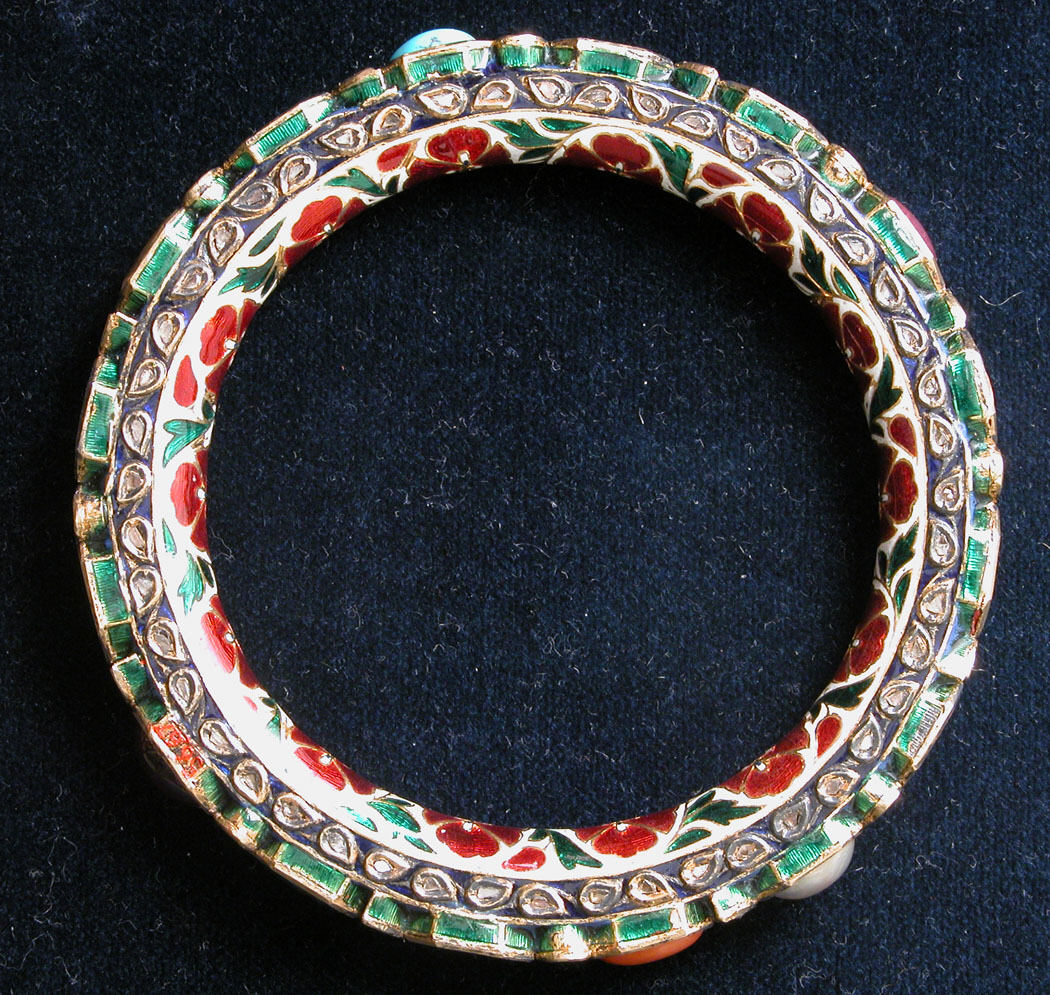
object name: bracelet, armlet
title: Bracelet or Armlet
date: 1701-1800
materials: enamel, gold, stone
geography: india